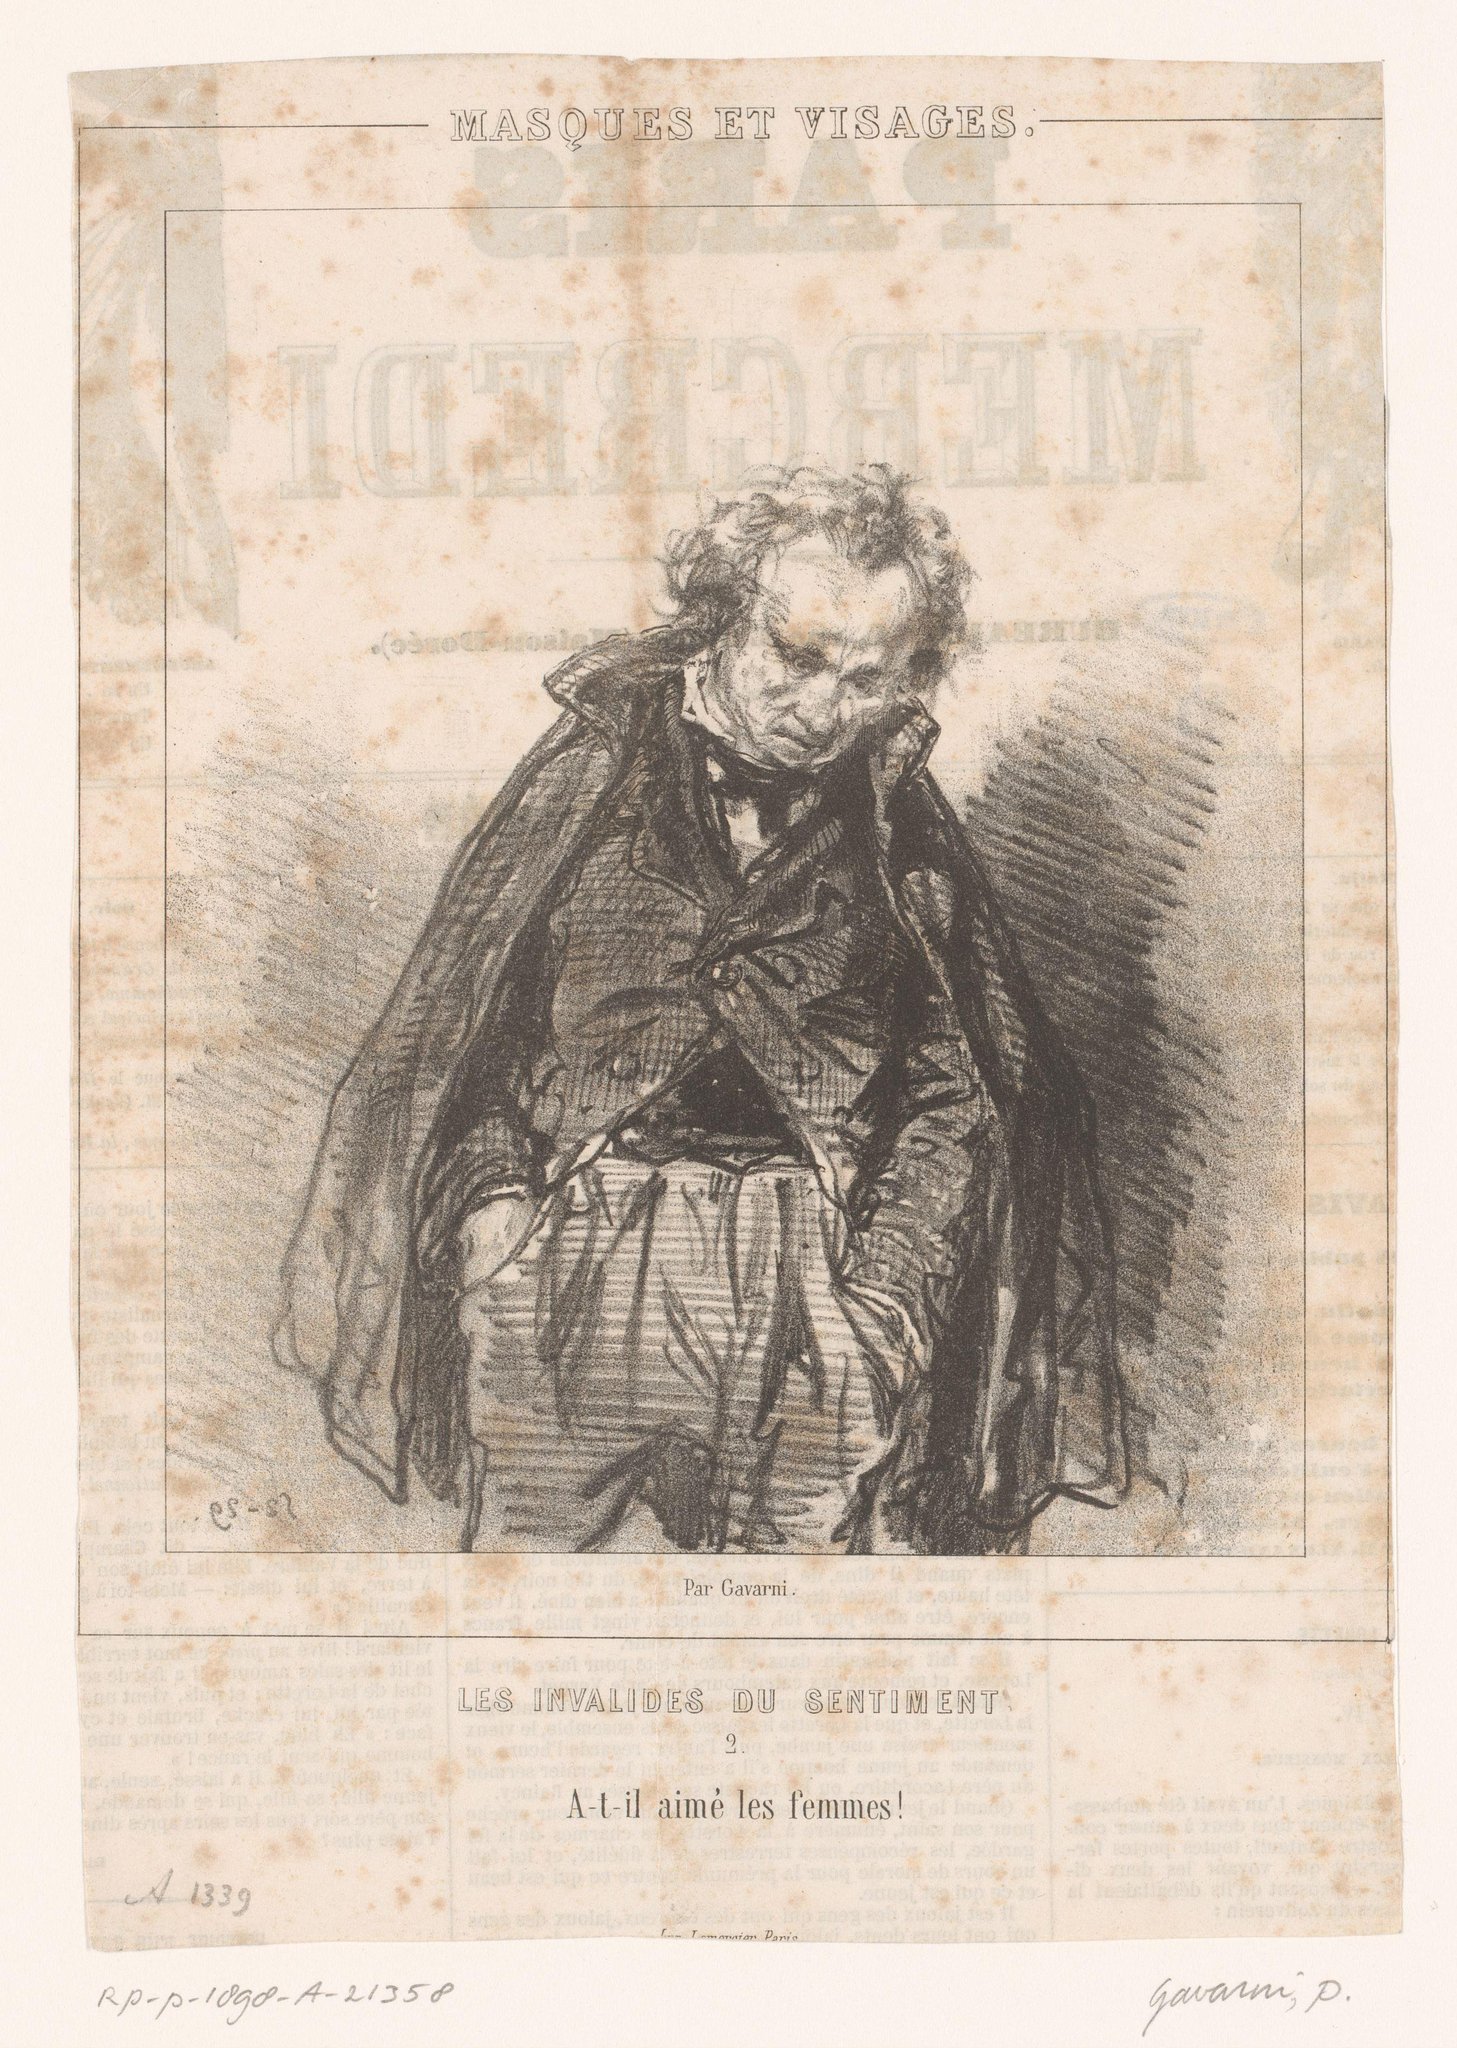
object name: cartoon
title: Oude man met handen in zijn zakken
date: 1852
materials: paper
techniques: lithograph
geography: paris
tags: standing figure, hand in the pocket - aa - both arms or hands, old man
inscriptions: collector's mark: Lugt 964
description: Prent gebruikt voor: Paris (journal), 24 november 1852.